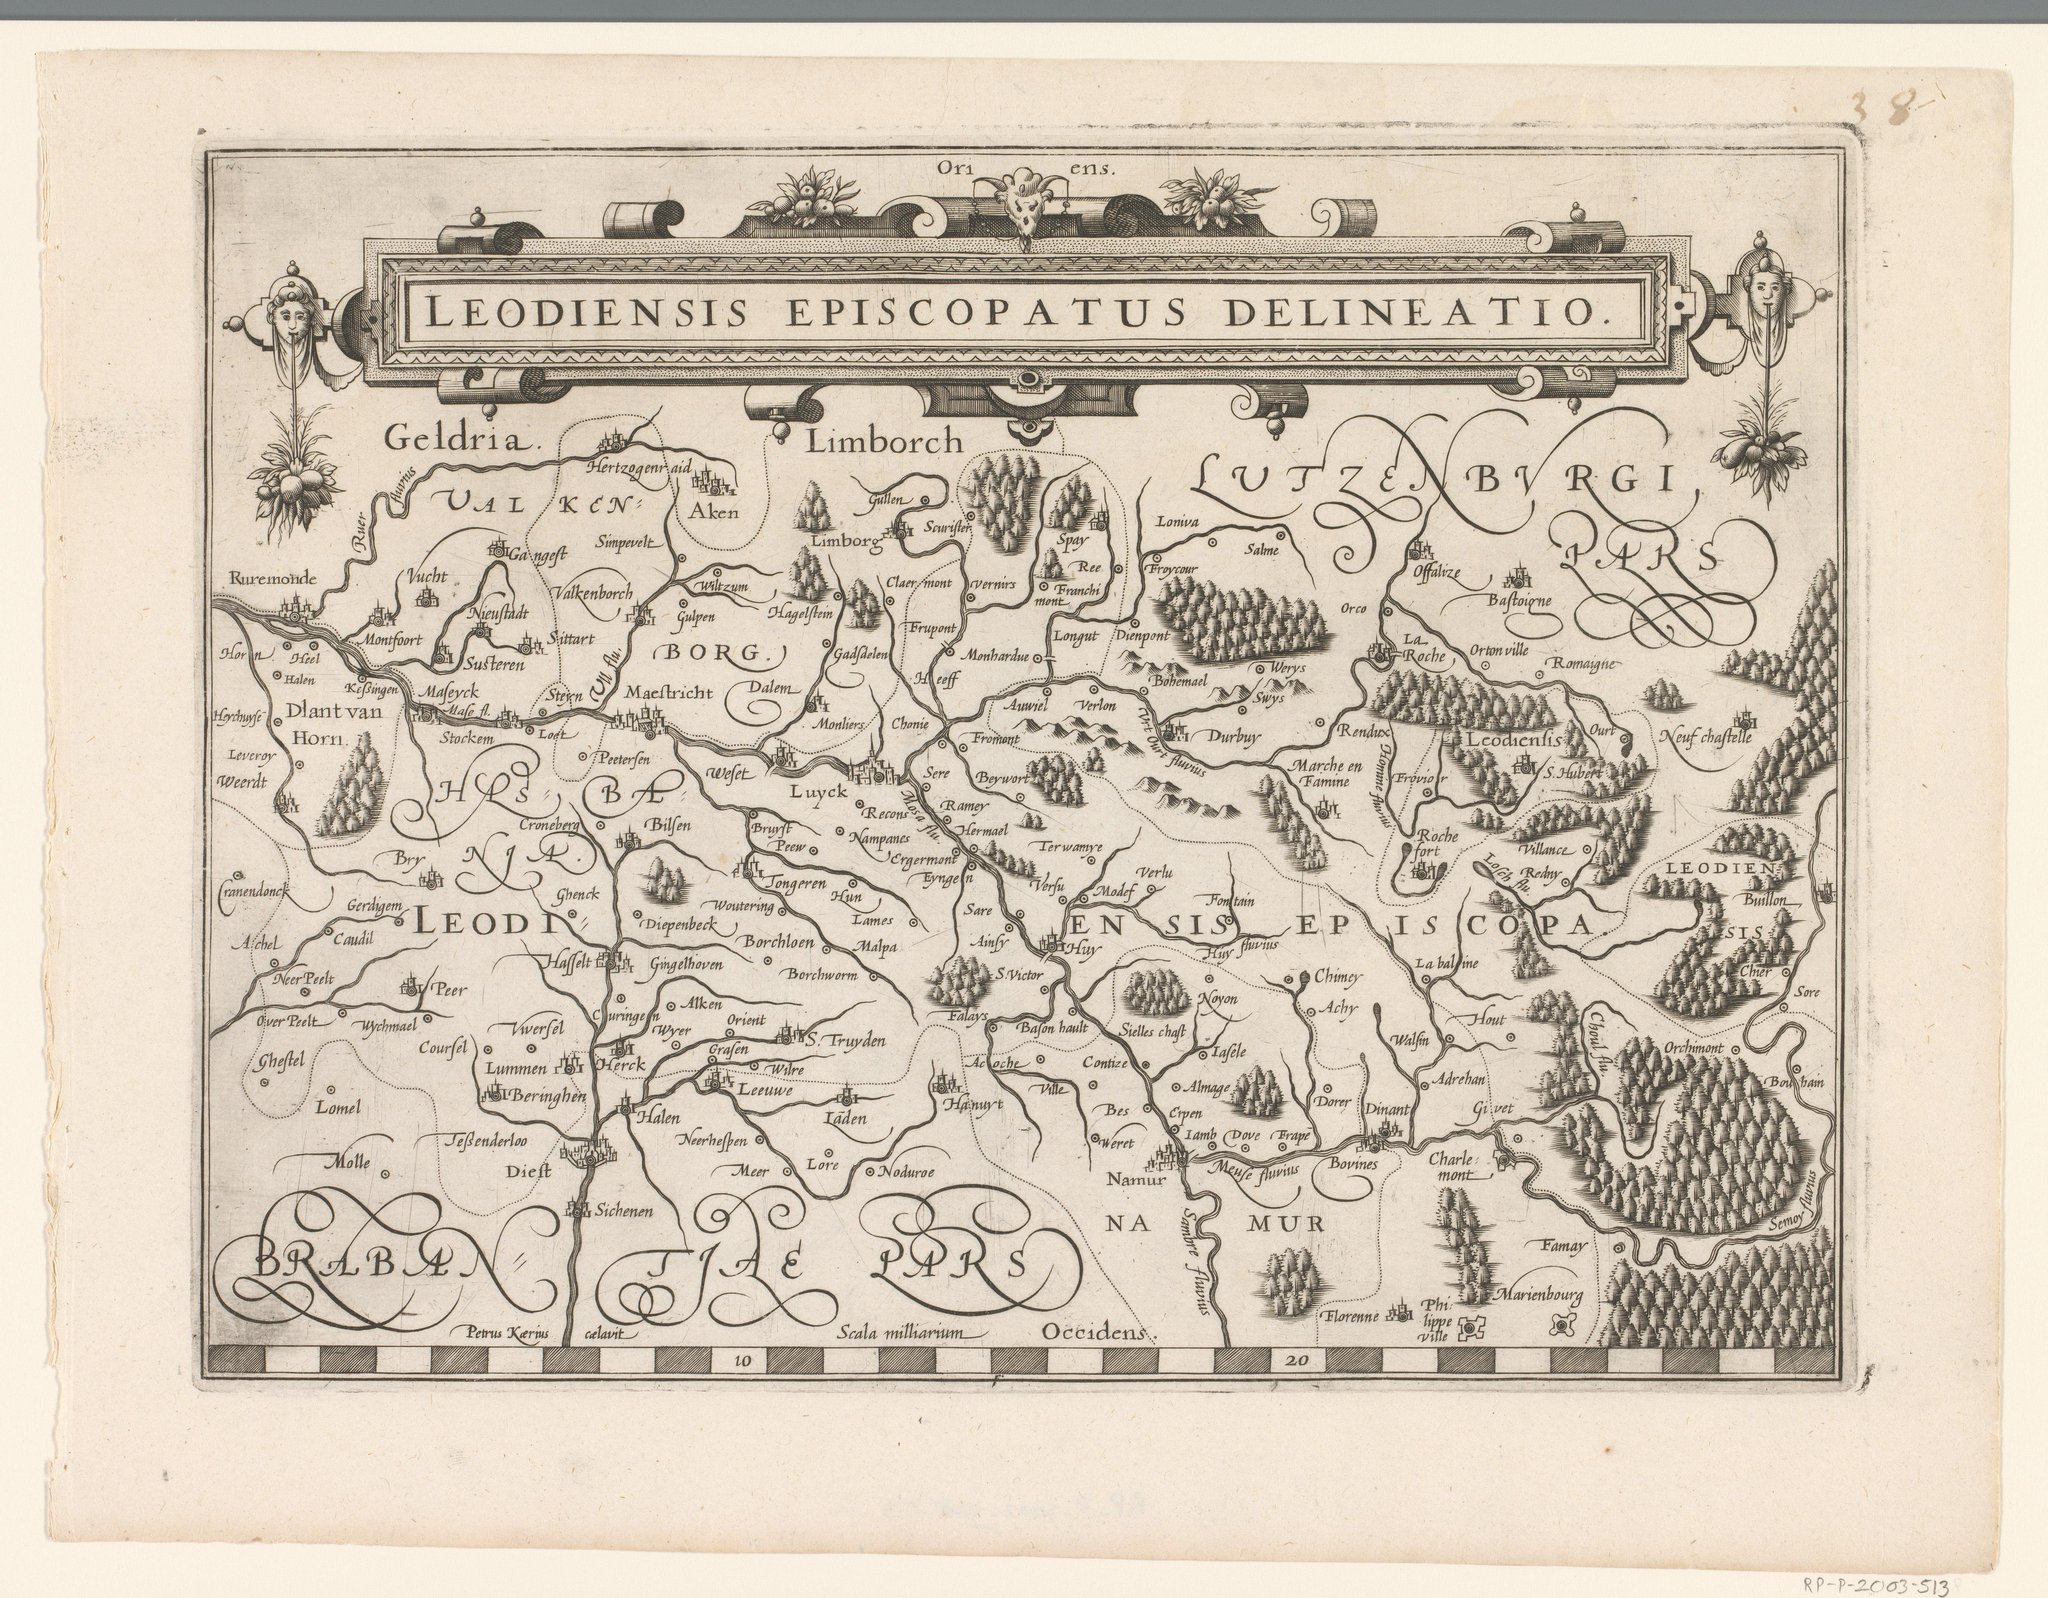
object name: national map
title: Leodiensis Episcopatus Delineatio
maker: pieter van der keere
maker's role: print maker, publisher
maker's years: 1571-1646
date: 1607-1609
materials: paper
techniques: engraving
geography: southern netherlands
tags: maps of separate countries or regions, prince-bishopric of liège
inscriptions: number: ‘38’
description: Kaart van het prins-bisdom Luik. Bovenaan een brede cartouche met de Latijnse titel. Onderdeel van de verzameling kaarten genomen uit een latere editie van: Descrittione di tutti i Paesi Bassi van Lodovico Guicciardini.